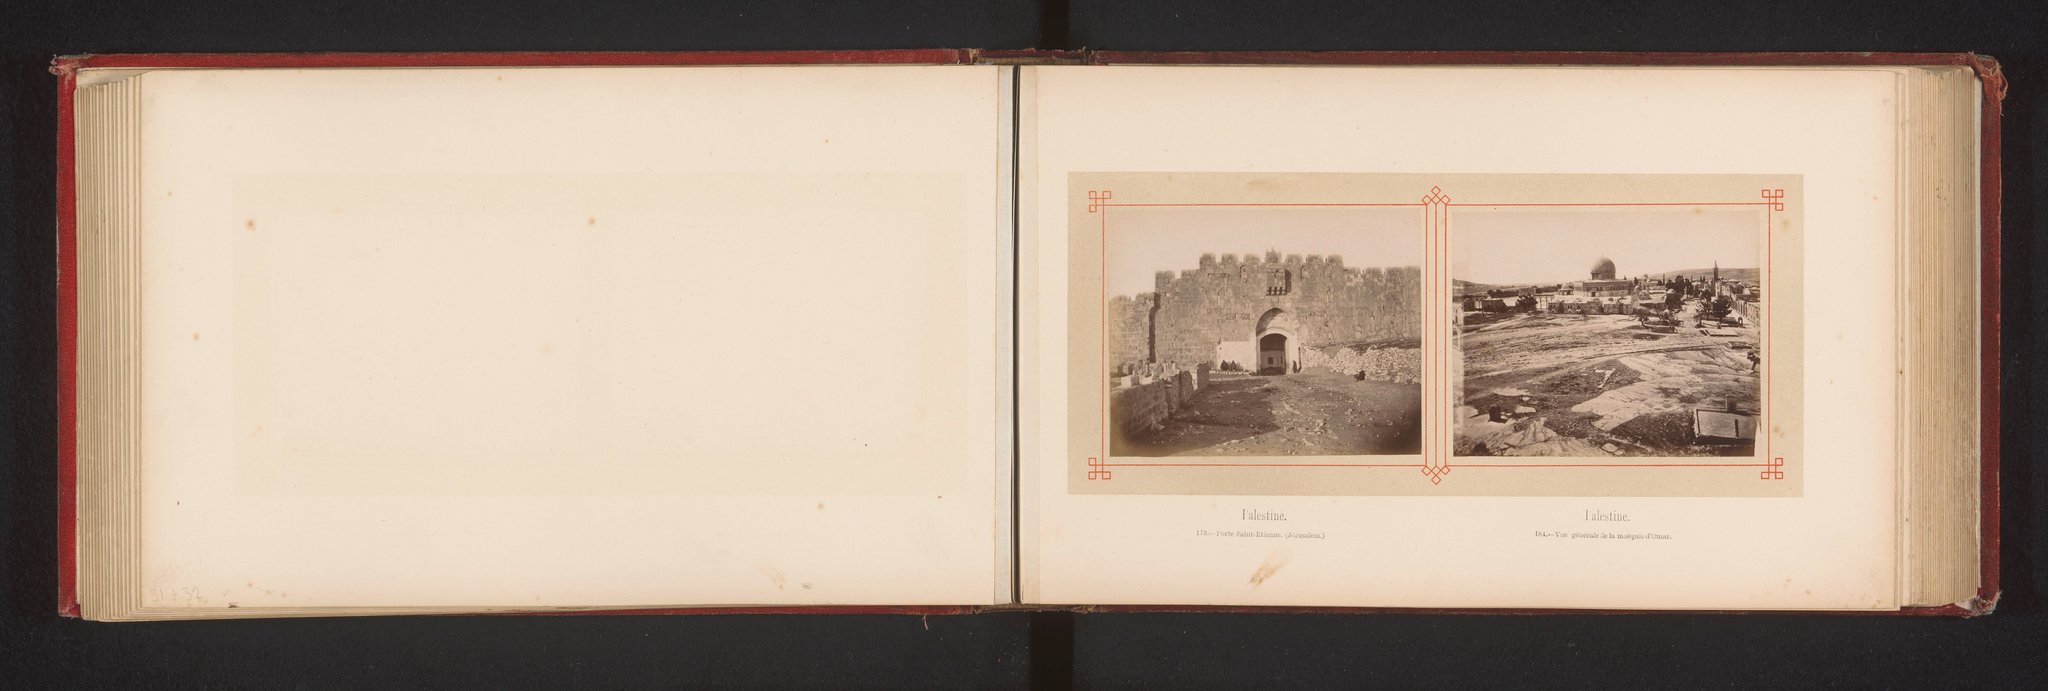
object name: page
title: Gezicht op de Leeuwenpoort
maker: félix bonfils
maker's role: fotograaf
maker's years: 1831-1885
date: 1873-1878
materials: photographic support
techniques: albumen print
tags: gate, entrance